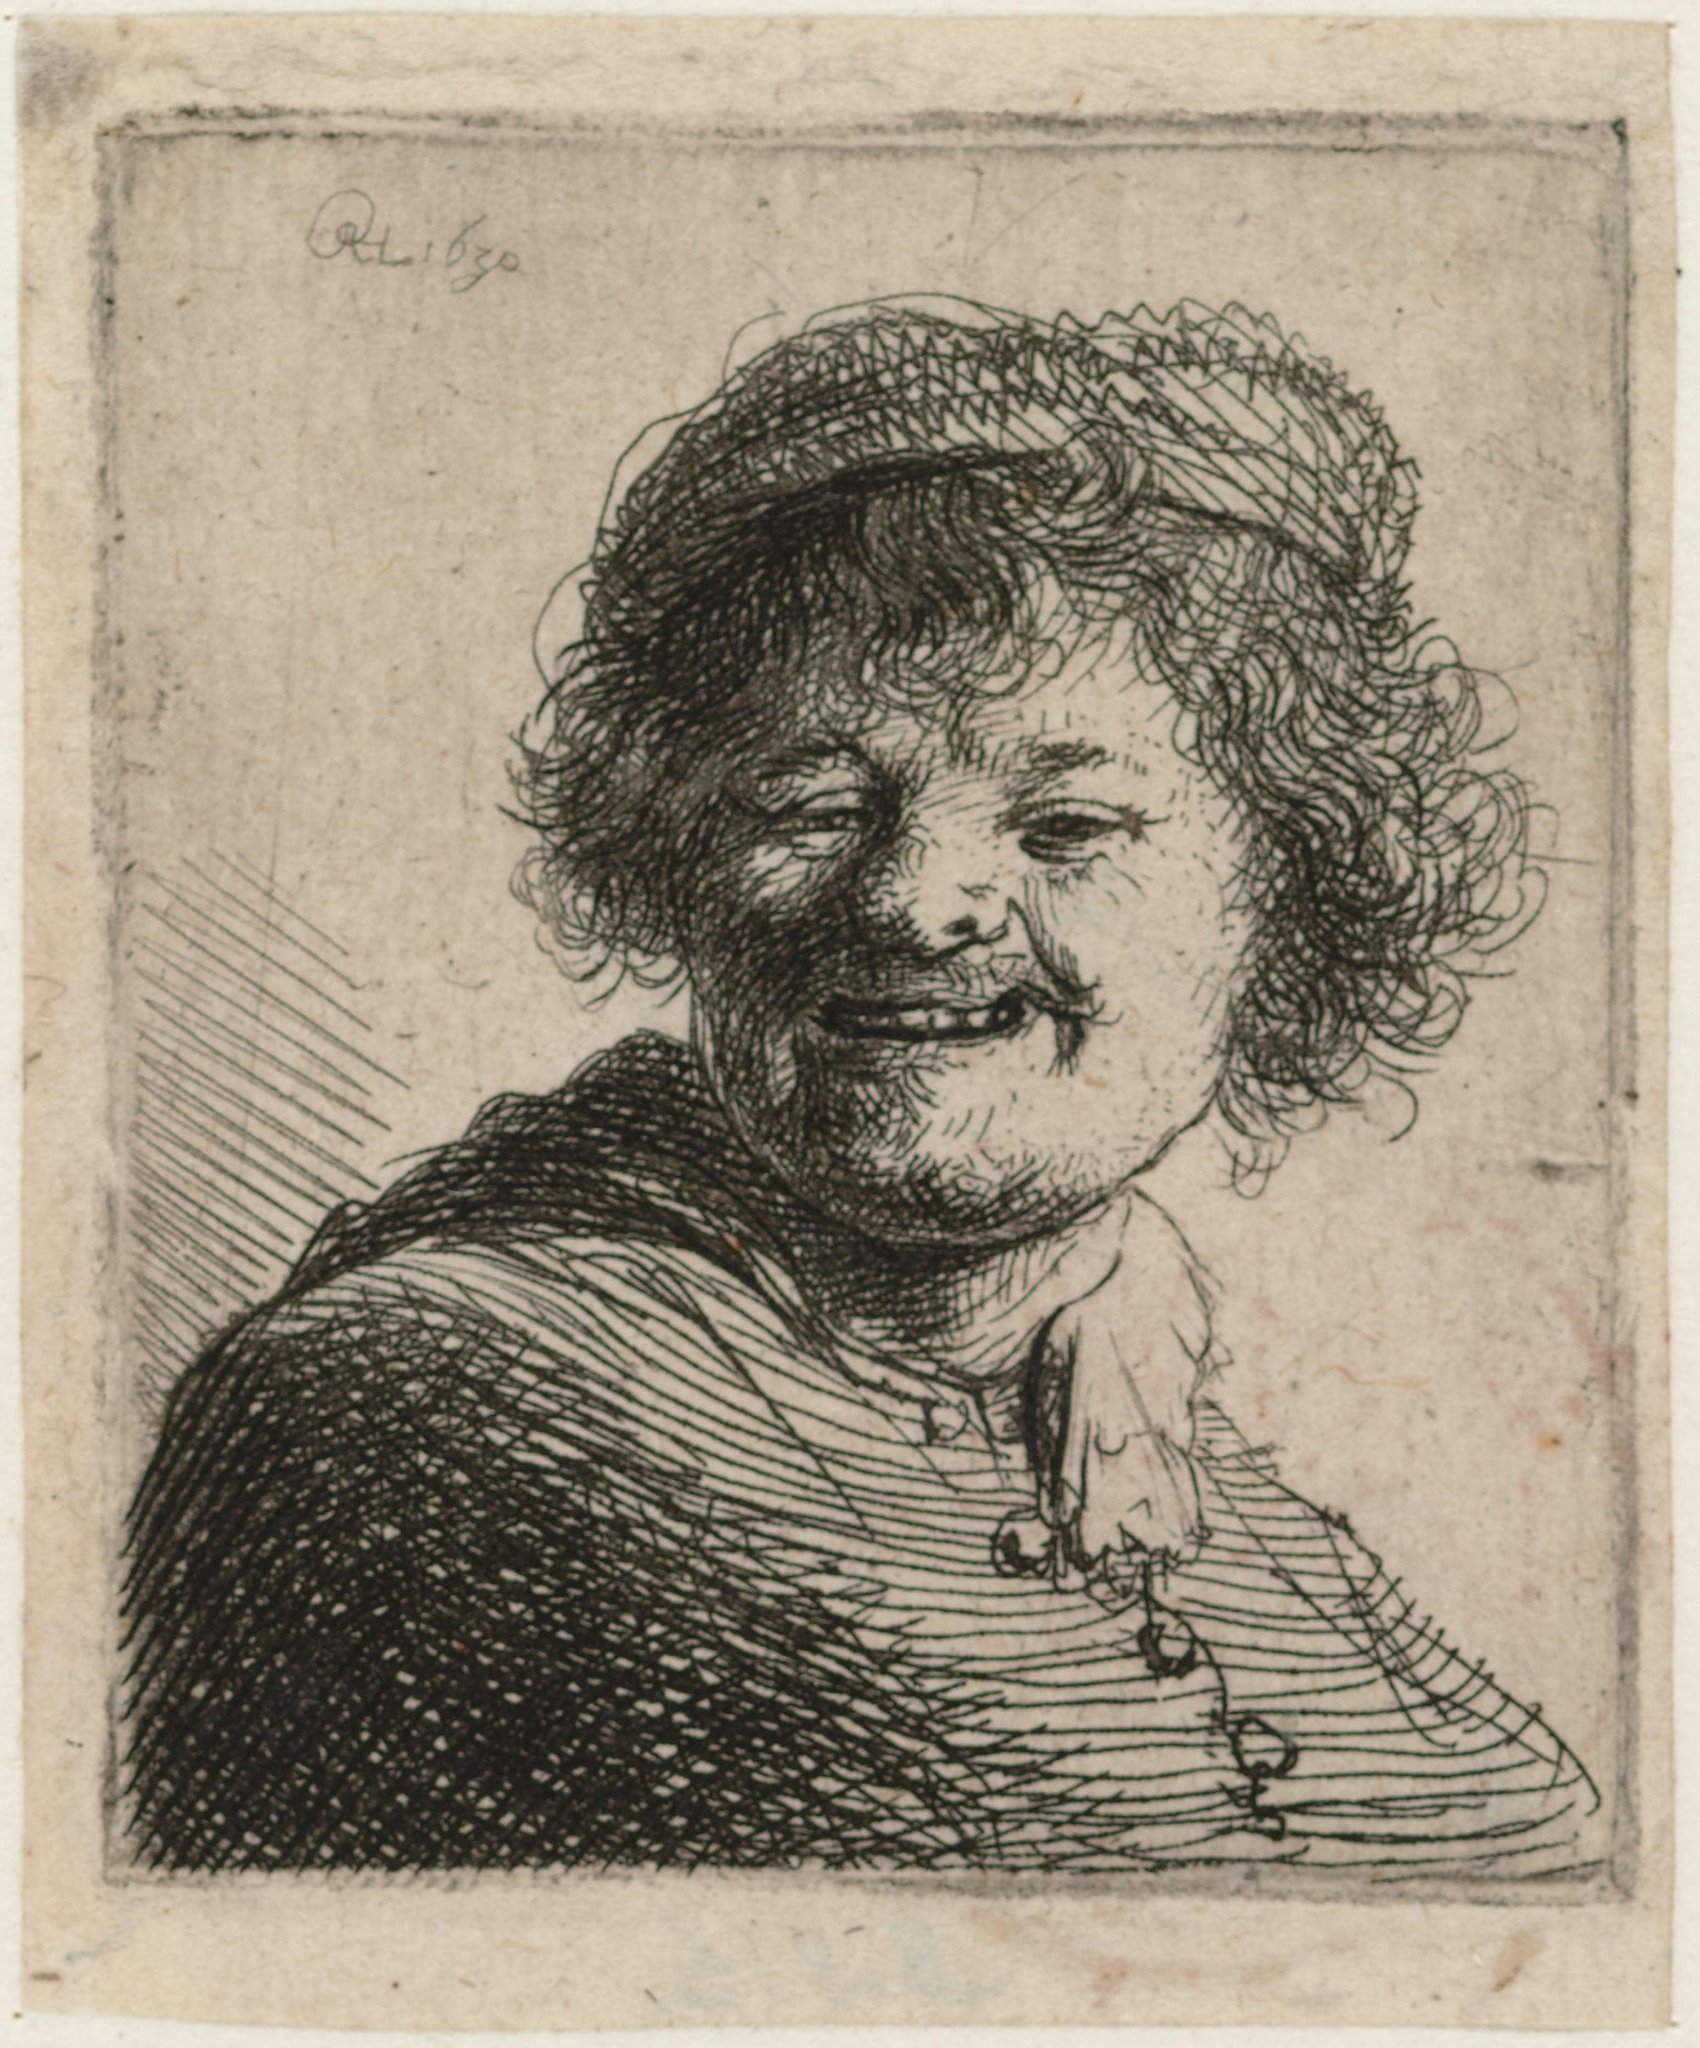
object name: print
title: Self-portrait in a cap: laughing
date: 1630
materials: paper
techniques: etching, intaglio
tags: amsterdam, painter, print maker, draughtsman, rembrandt van rijn, head-gear: cap (+ men's clothes)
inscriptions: monogram and date: ‘RHL 1630’, mark: Lugt 240